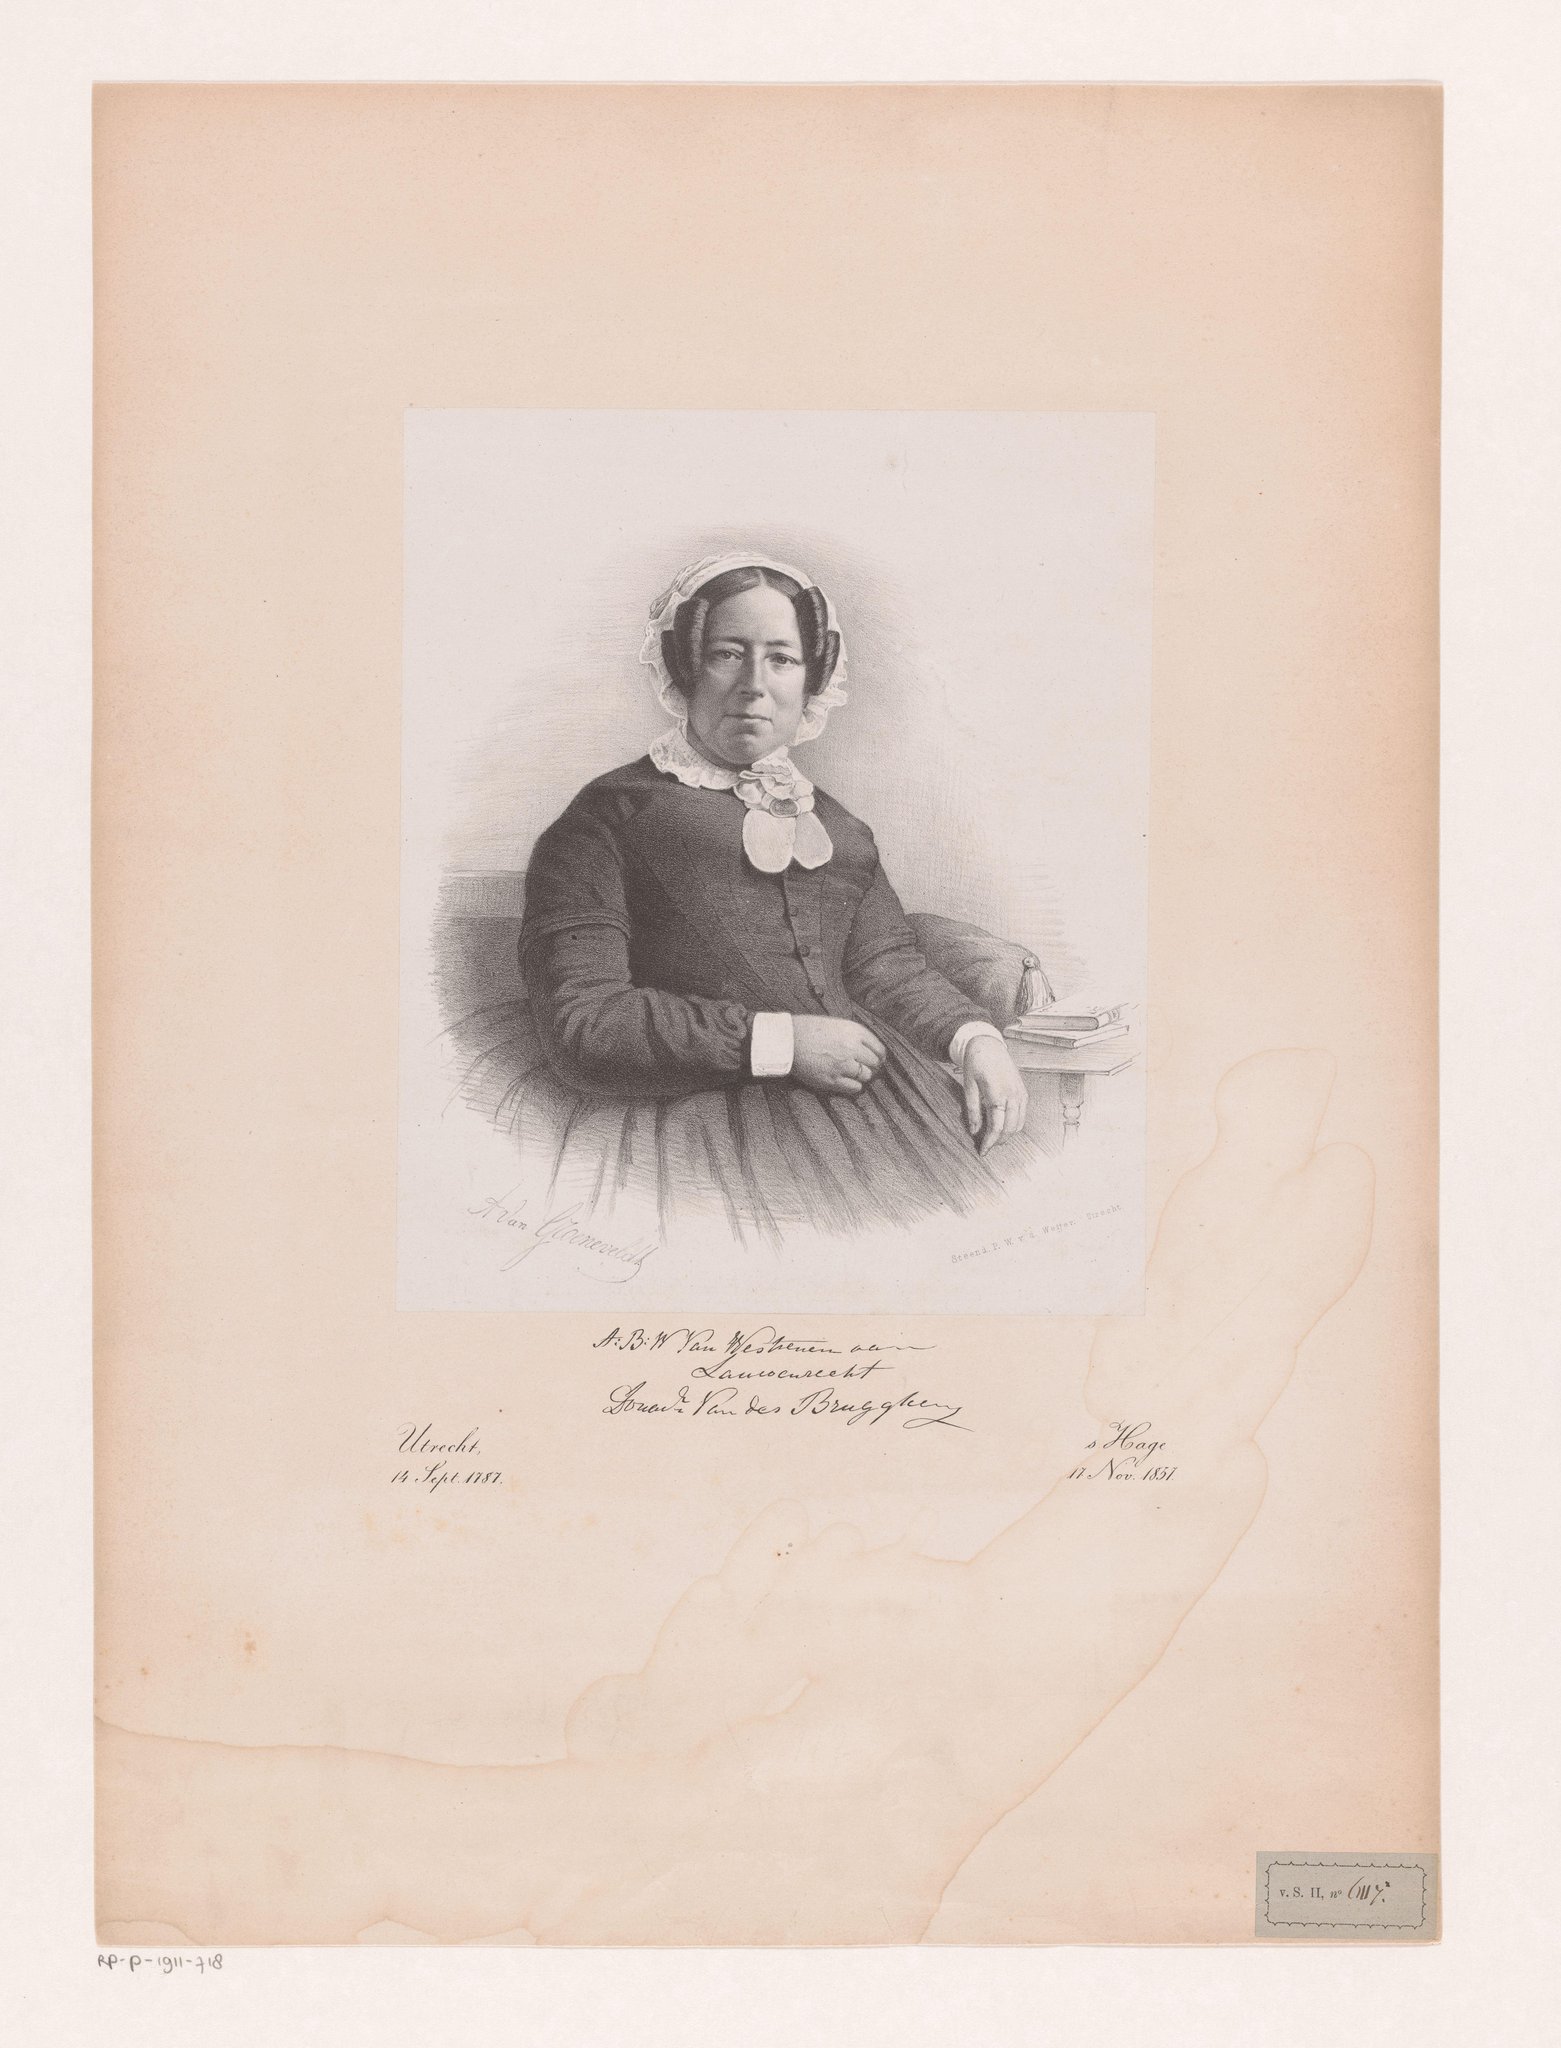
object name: print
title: Portret van Arnoudina Berendina Wilhelmina van Westrenen van Lauwerecht Douair van der Brugghen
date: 1834-1851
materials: paper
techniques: lithograph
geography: utrecht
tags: historical persons (+ (full) bust portrait)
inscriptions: collector's mark: Lugt 2228